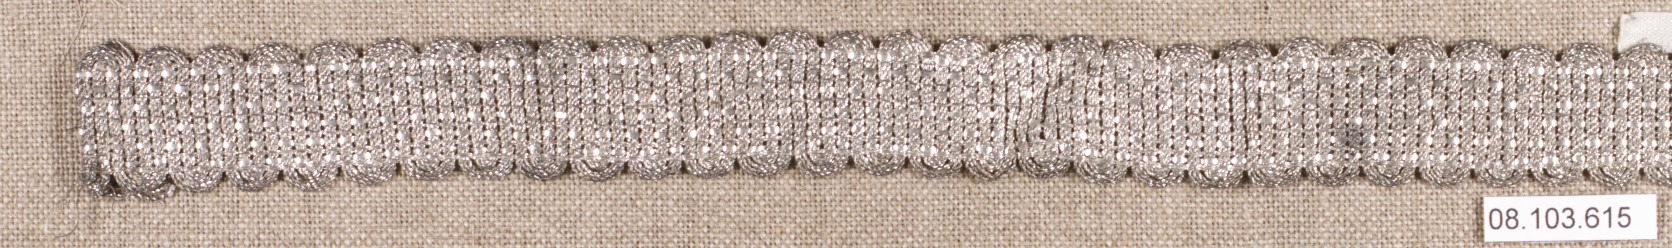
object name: galloon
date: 1701-1800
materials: metal thread